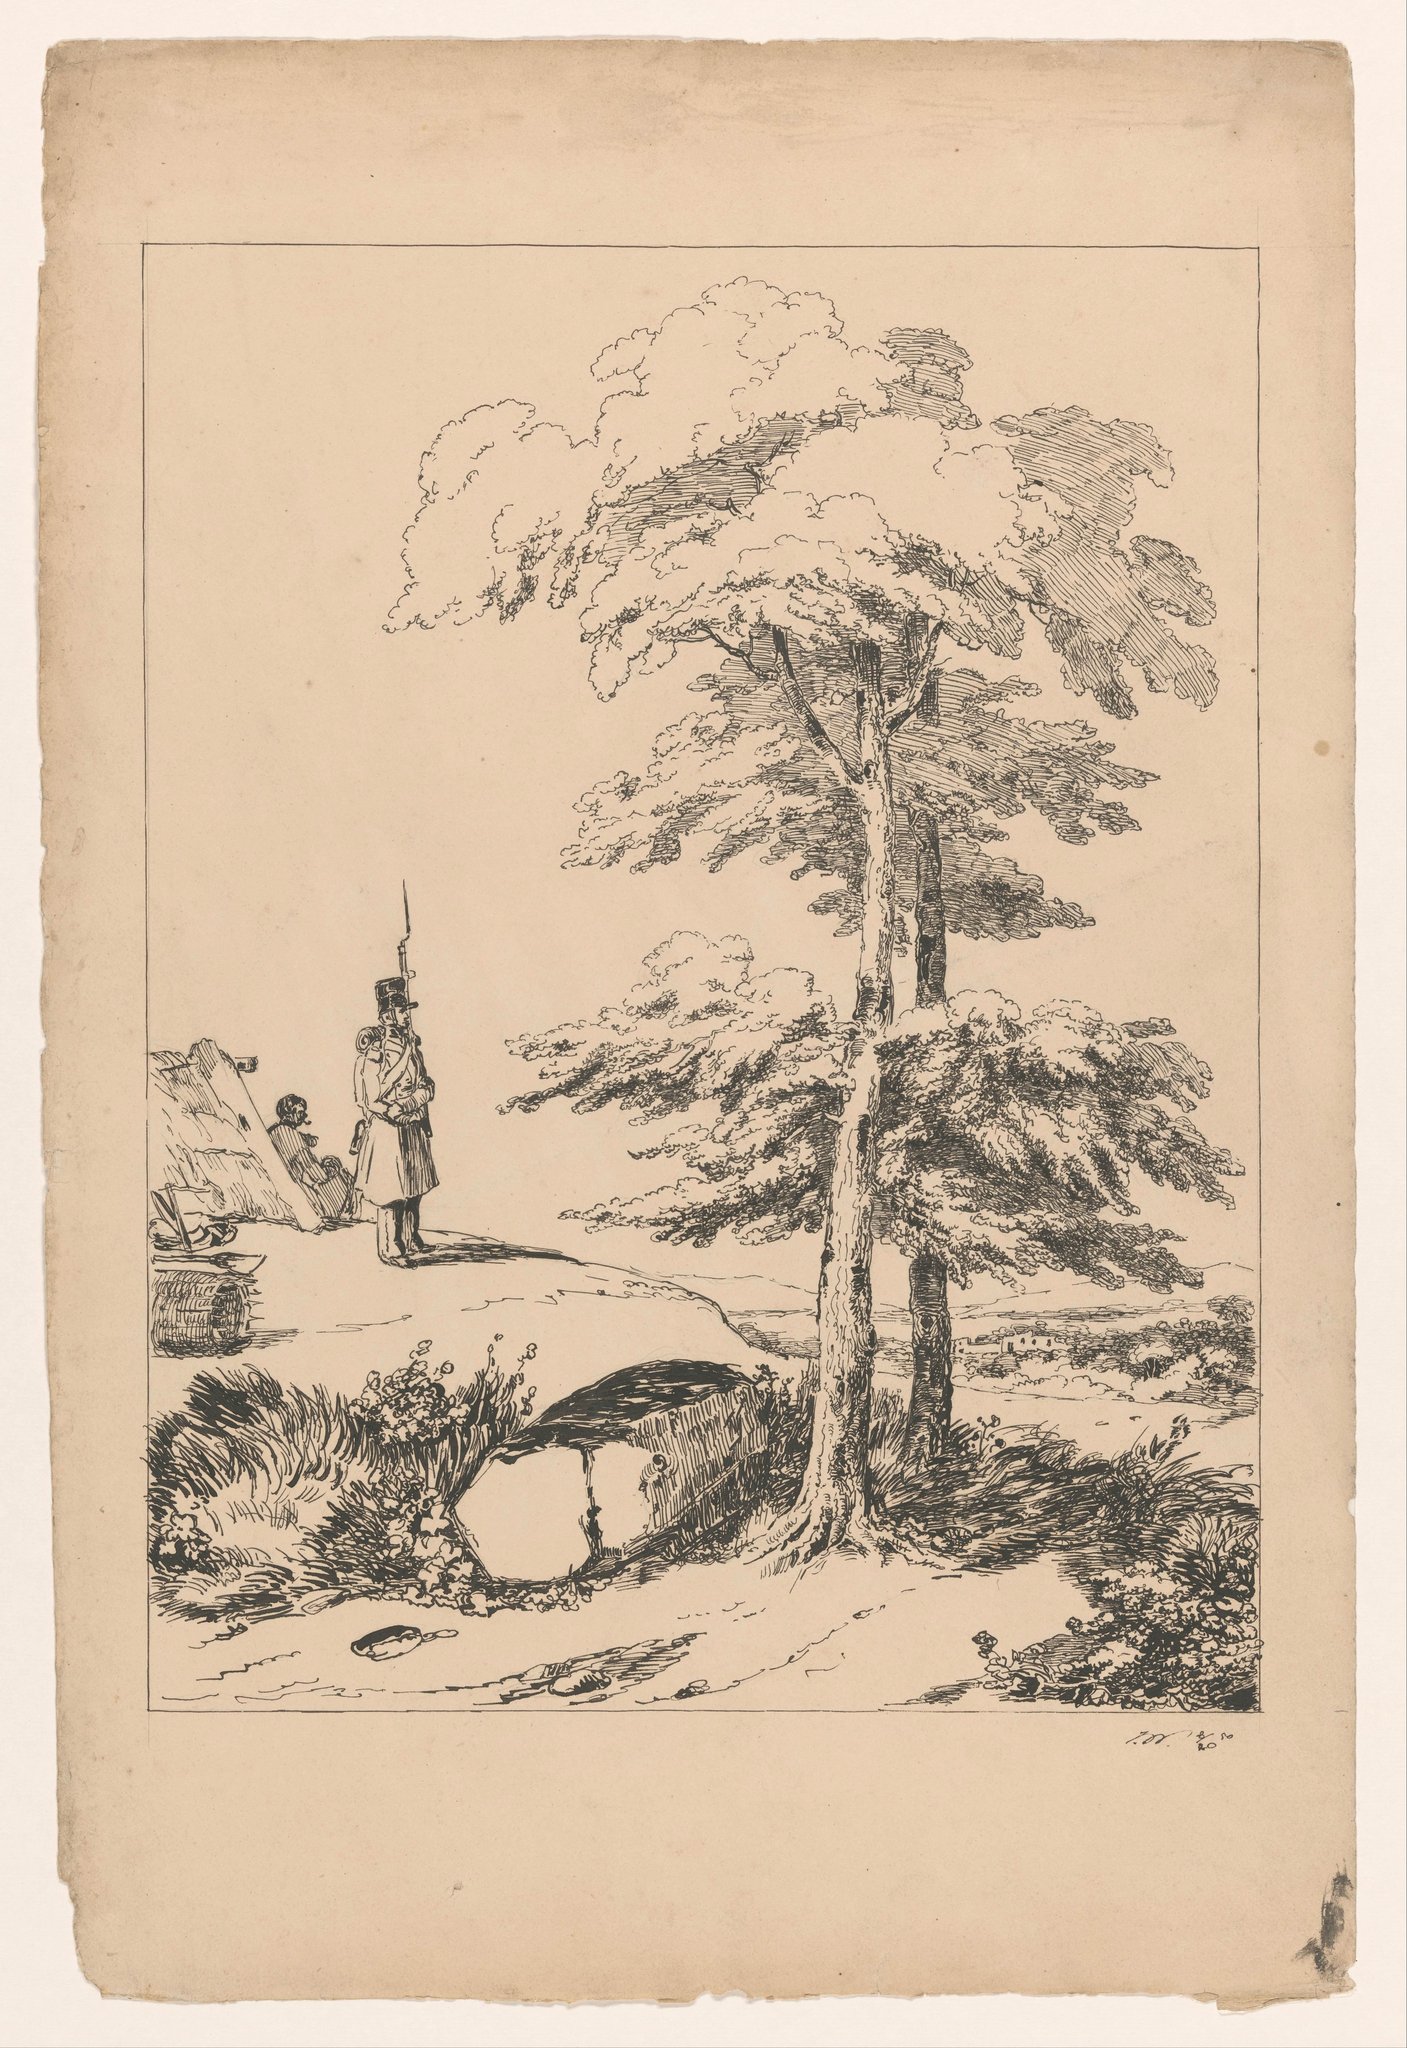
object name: drawing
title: Landschap met soldaat op wacht voor een tent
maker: isaac weissenbruch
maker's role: print maker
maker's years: 1826-1912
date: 1850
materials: ink, paper, pencil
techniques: pen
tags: landscapes, hacking and thrusting weapons (bayonet), land forces, firearms: rifle